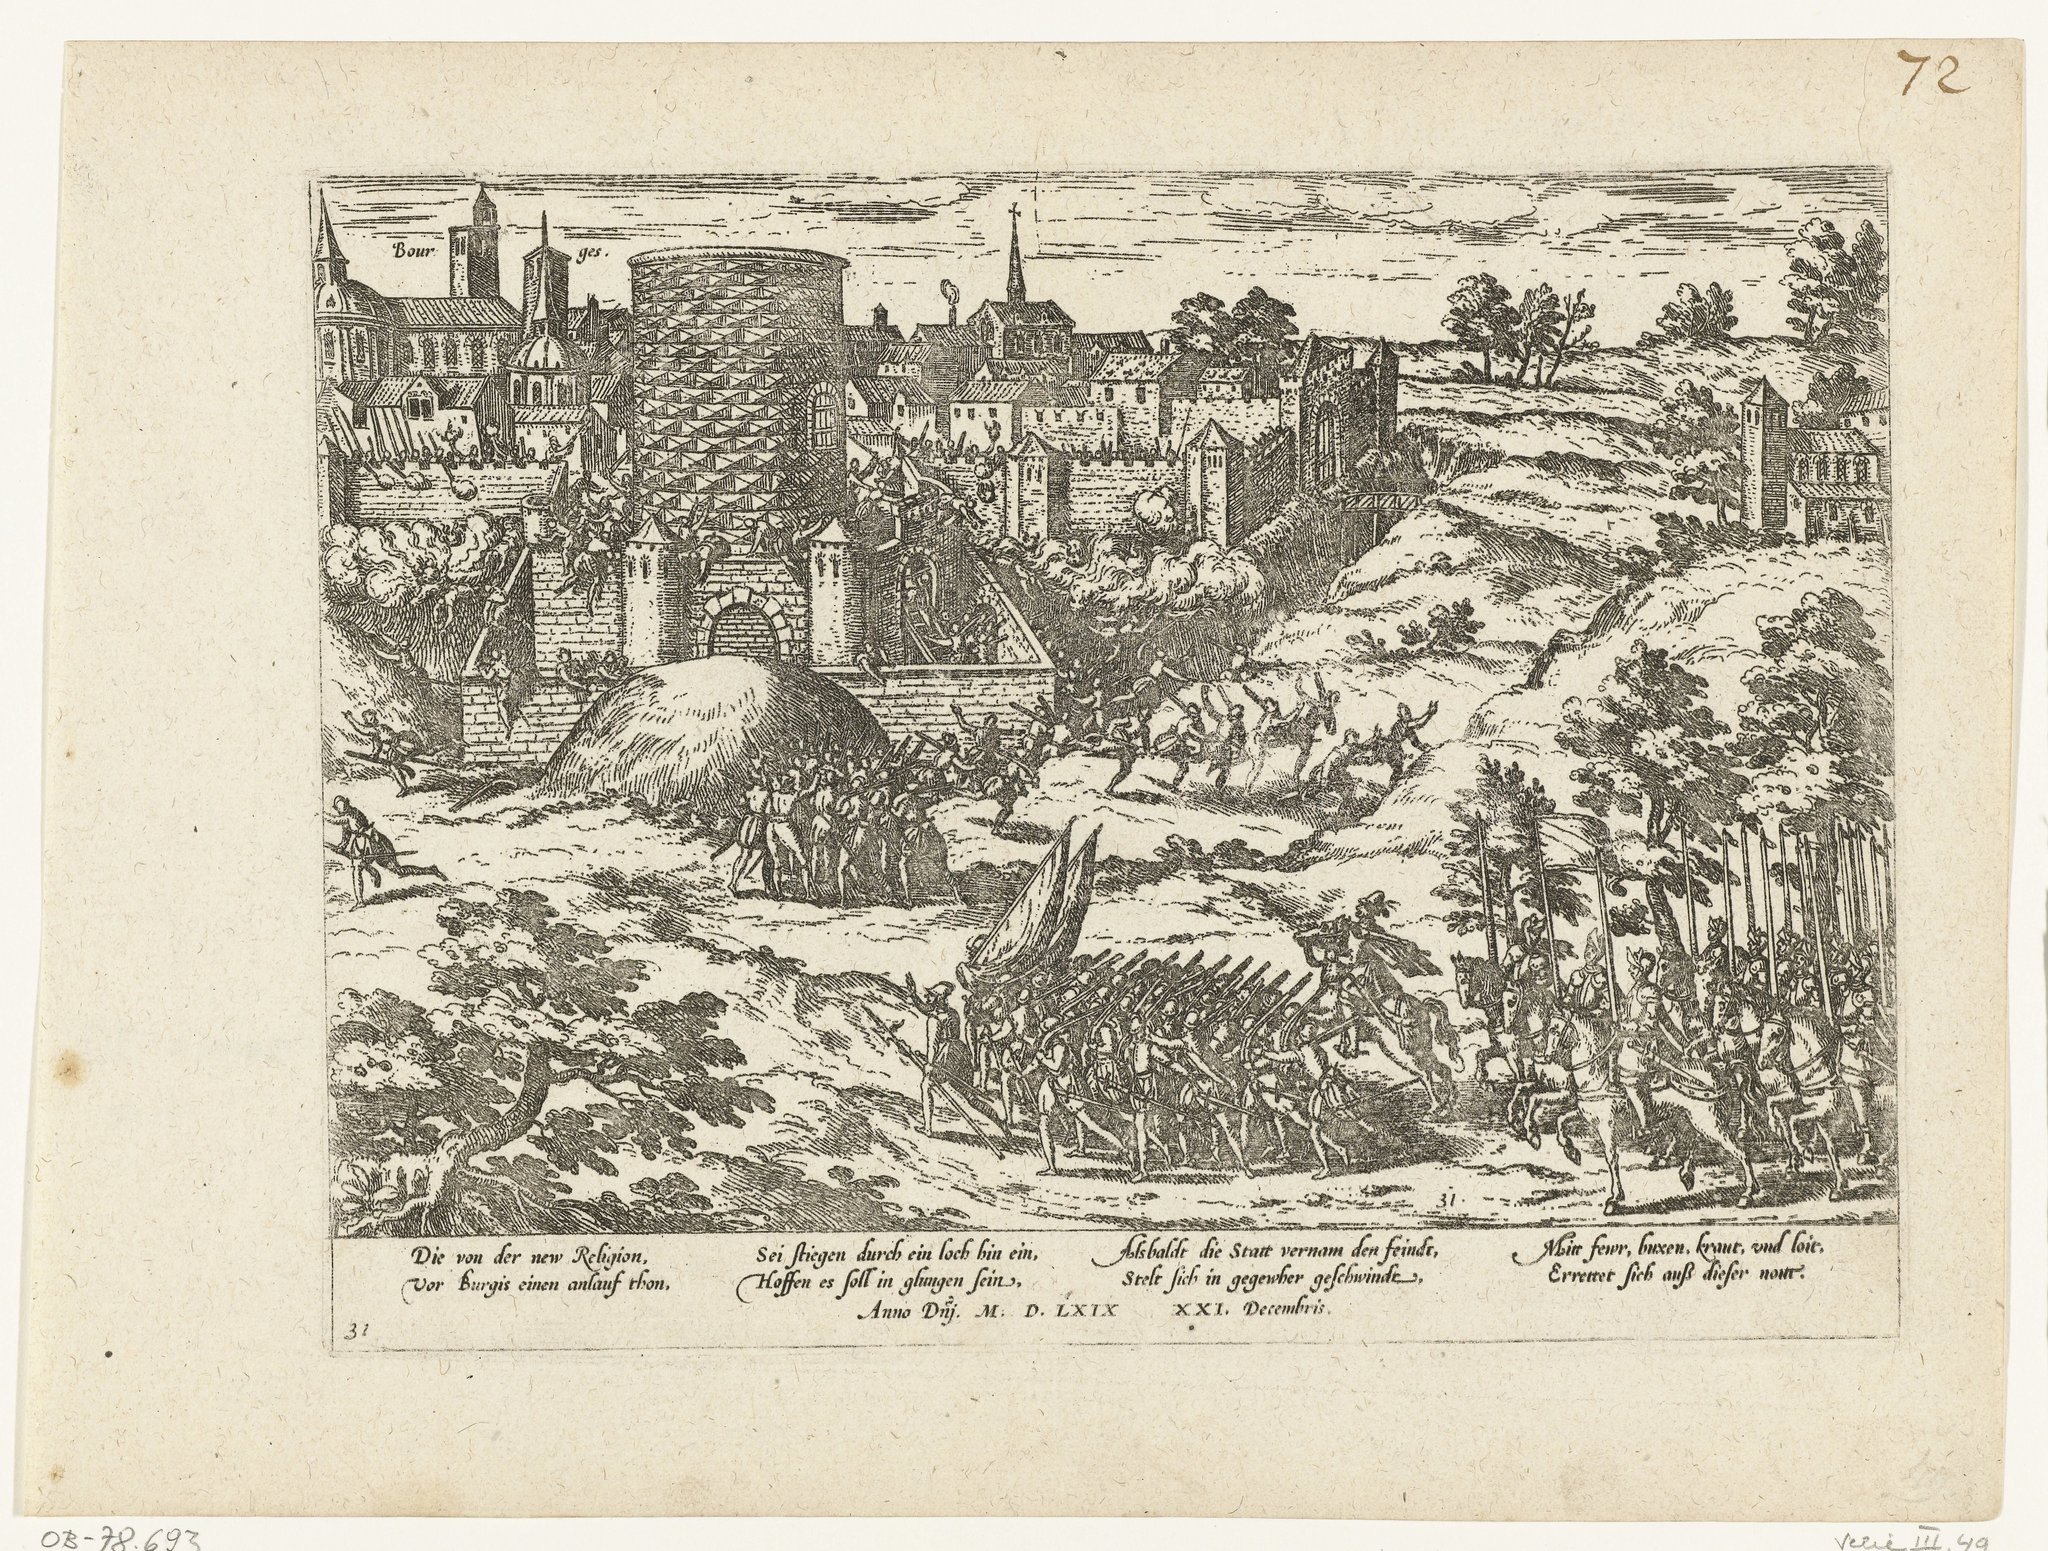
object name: history print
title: Aanslag van de hugenoten op Bourges verijdeld, 1569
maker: frans hogenberg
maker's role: print maker, publisher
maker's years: 1538-1590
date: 1565-1573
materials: paper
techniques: etching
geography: cologne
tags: siege, position war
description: Gekopieerd naar de prent in: Jean Tortorel et Jacques Perrissin, Premier volume contenant quarante tableaux ou Histoires diverses qui sont memorables touchant les Guerres, Massacres et Troubles advenus en France en ces dernieres annees : le tout recueilly selon le tesmoignange de ceux qui y ont esté en personne et qui les ont veus : lesquels sont pourtraits à la vérité, Genève ca. 1570. Bibliotheek Rijksmuseum: 329 A 2, pl. 39.